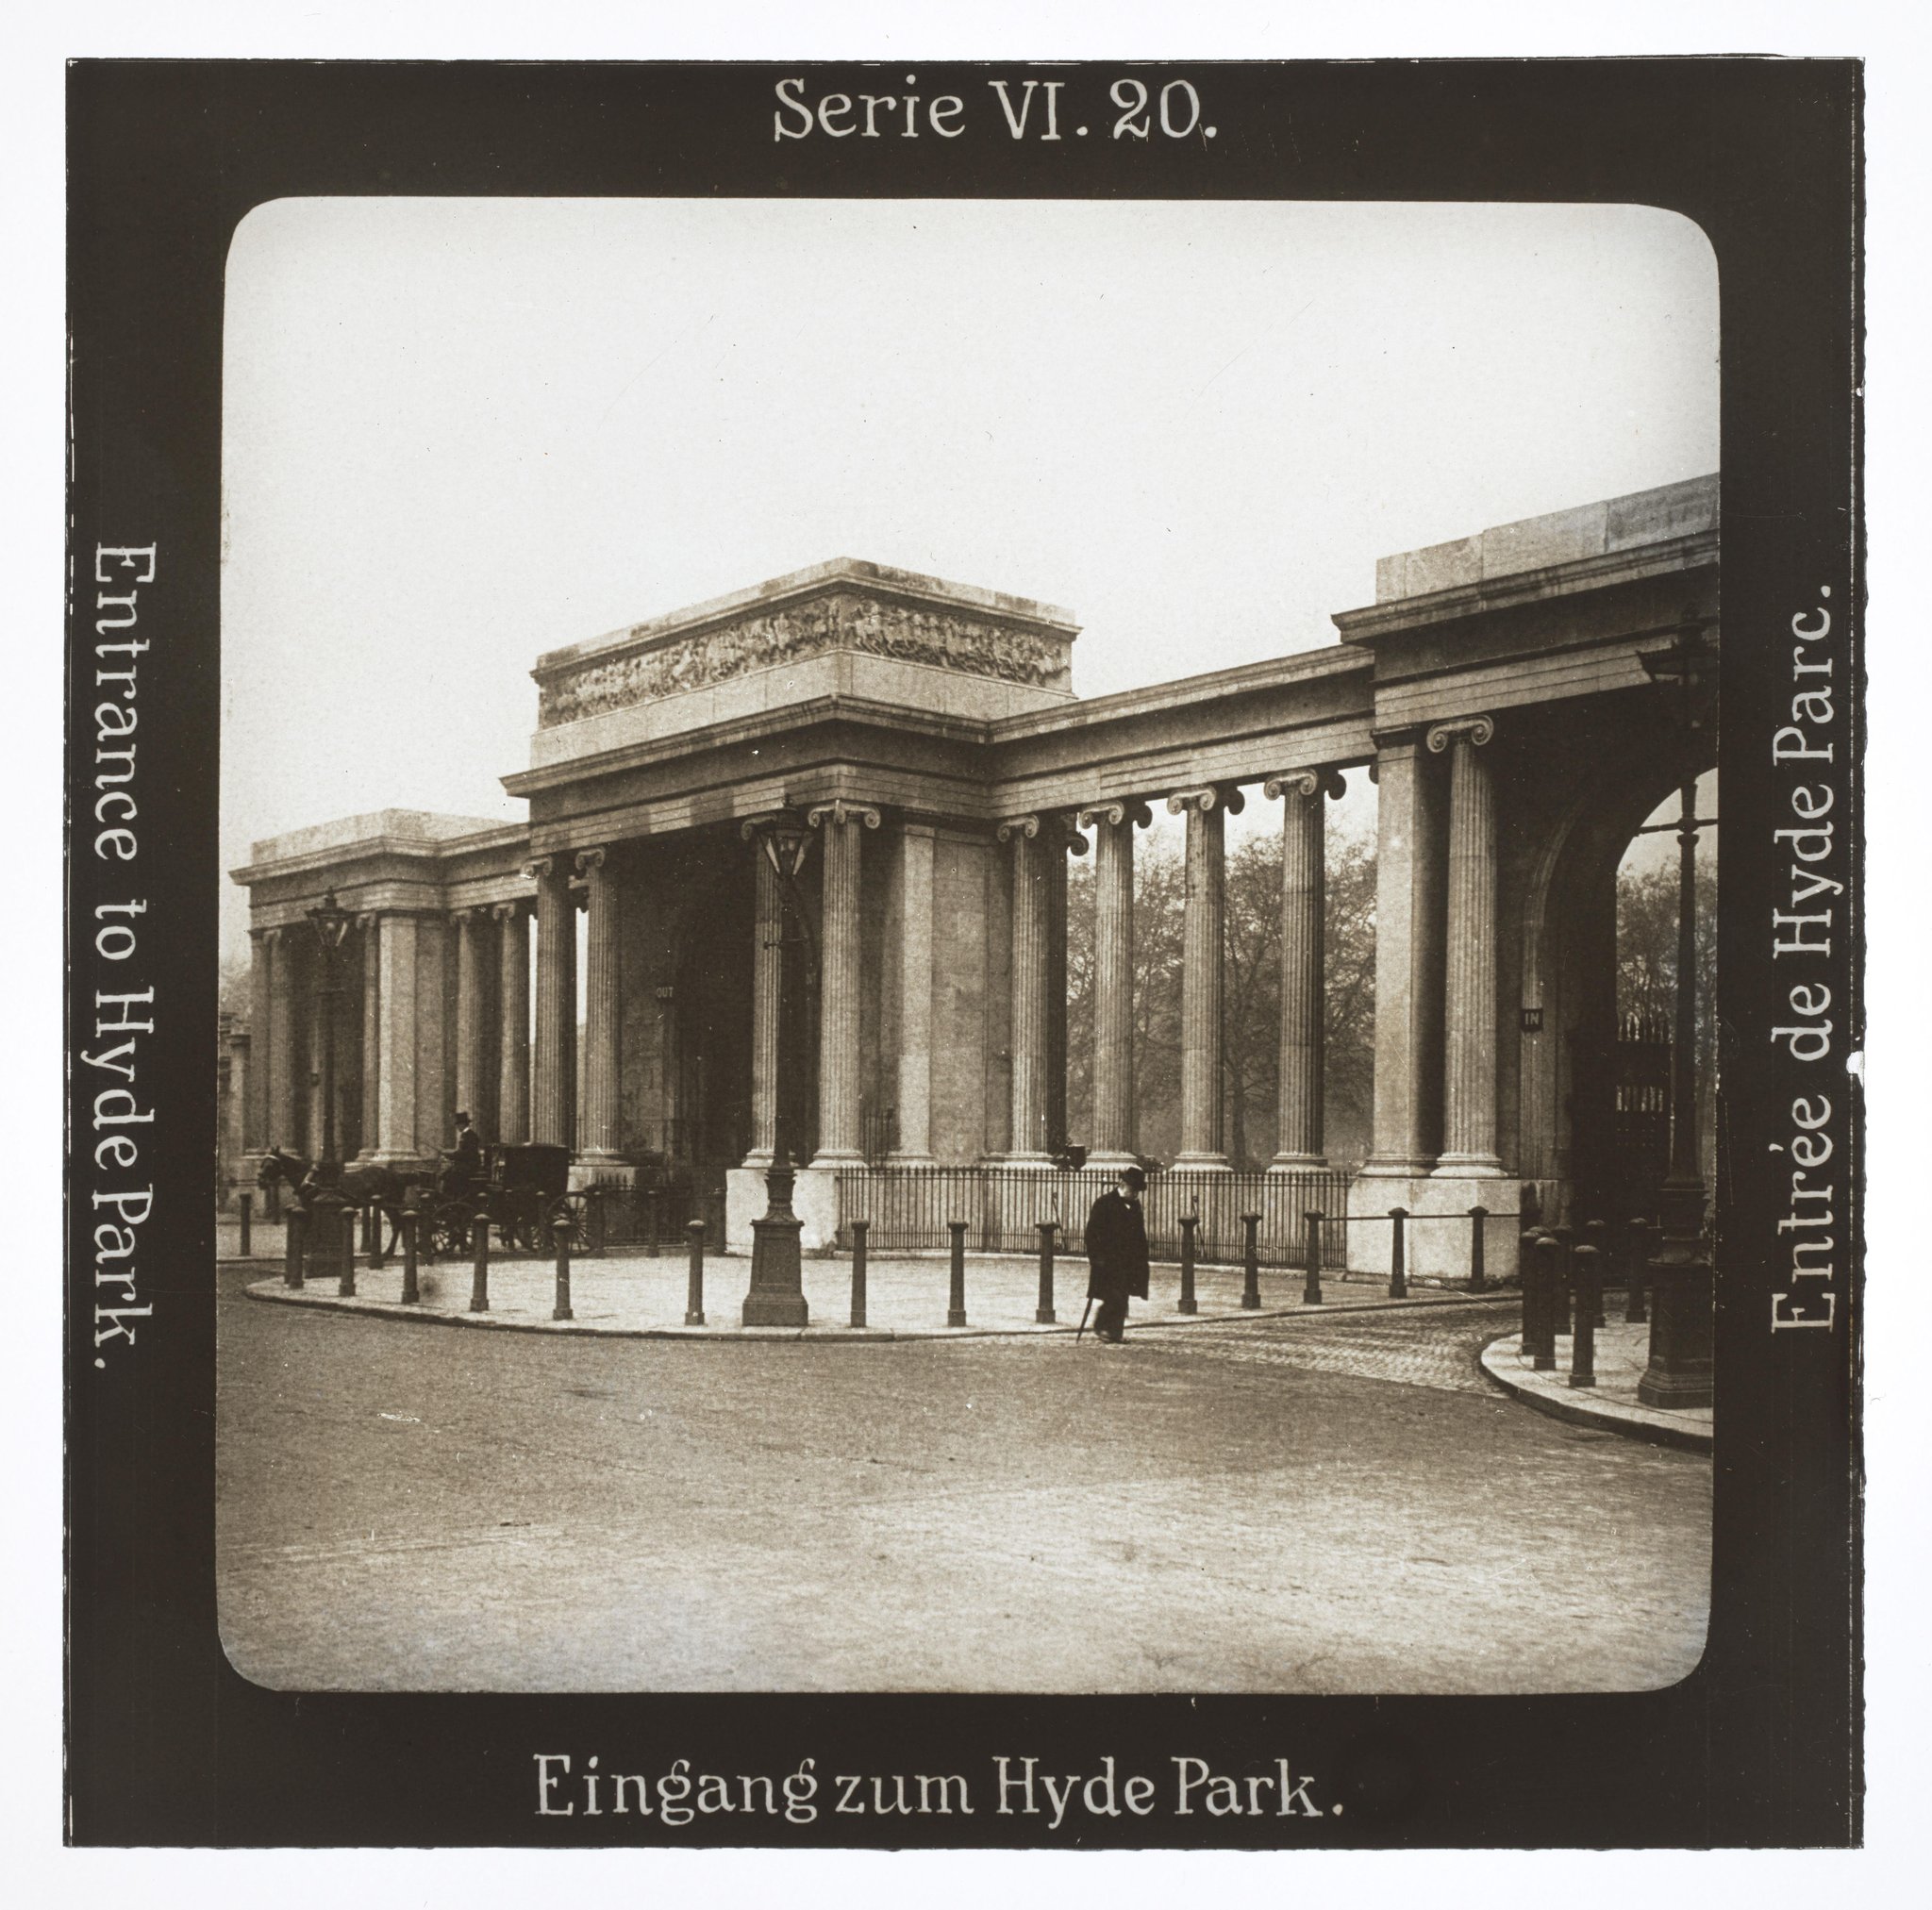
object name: lantern slide photographic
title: Gezicht op de ionische colonnade van Decimus Burton bij Hyde Park Corner, Londen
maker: Anonymous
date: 1900-1906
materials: glass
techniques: gelatin silver transparency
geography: germany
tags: colonnade, gate, entrance, public gardens, park